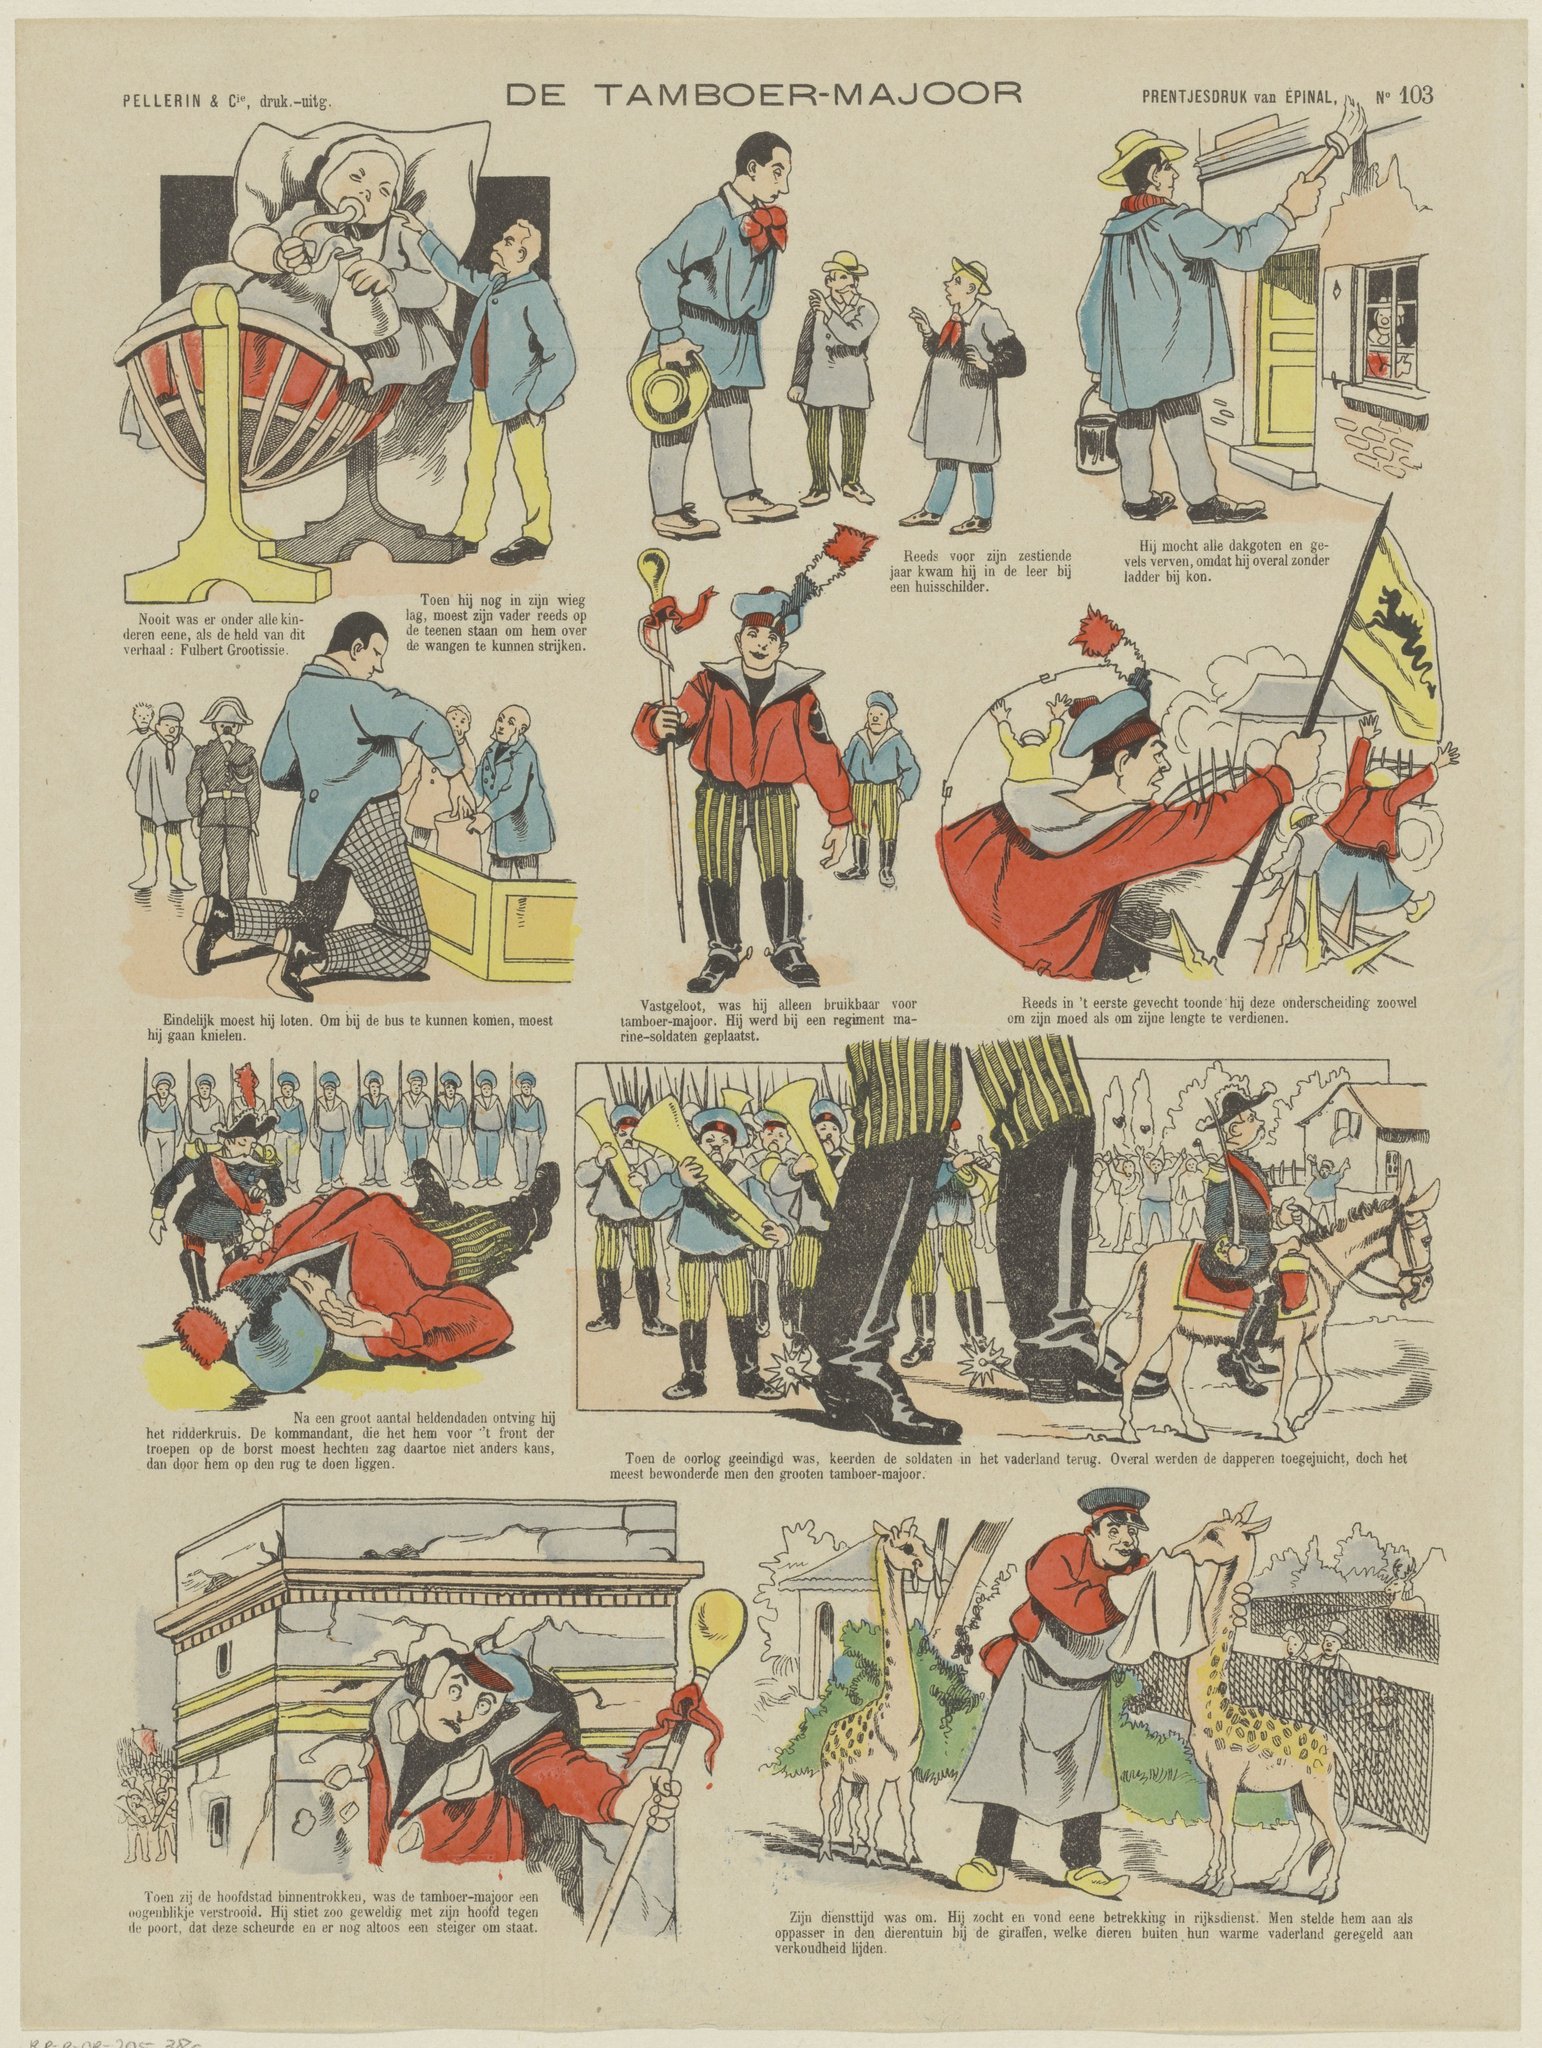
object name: print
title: Prentjesdruk van Epinal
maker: Anonymous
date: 1902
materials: paper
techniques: colour, letterpress printing, lithograph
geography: epinal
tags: caretakers ~ zoological garden, tales and fairy tales, the soldier; the soldier's life, giants, colossi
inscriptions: collector's mark: Lugt 2760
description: Blad met 16 voorstellingen over een reus die tamboer-majoor wordt in het leger en vervolgens in de dierentuin gaat werken. Onder elke afbeelding een onderschrift. Genummerd rechtsboven: No 103.